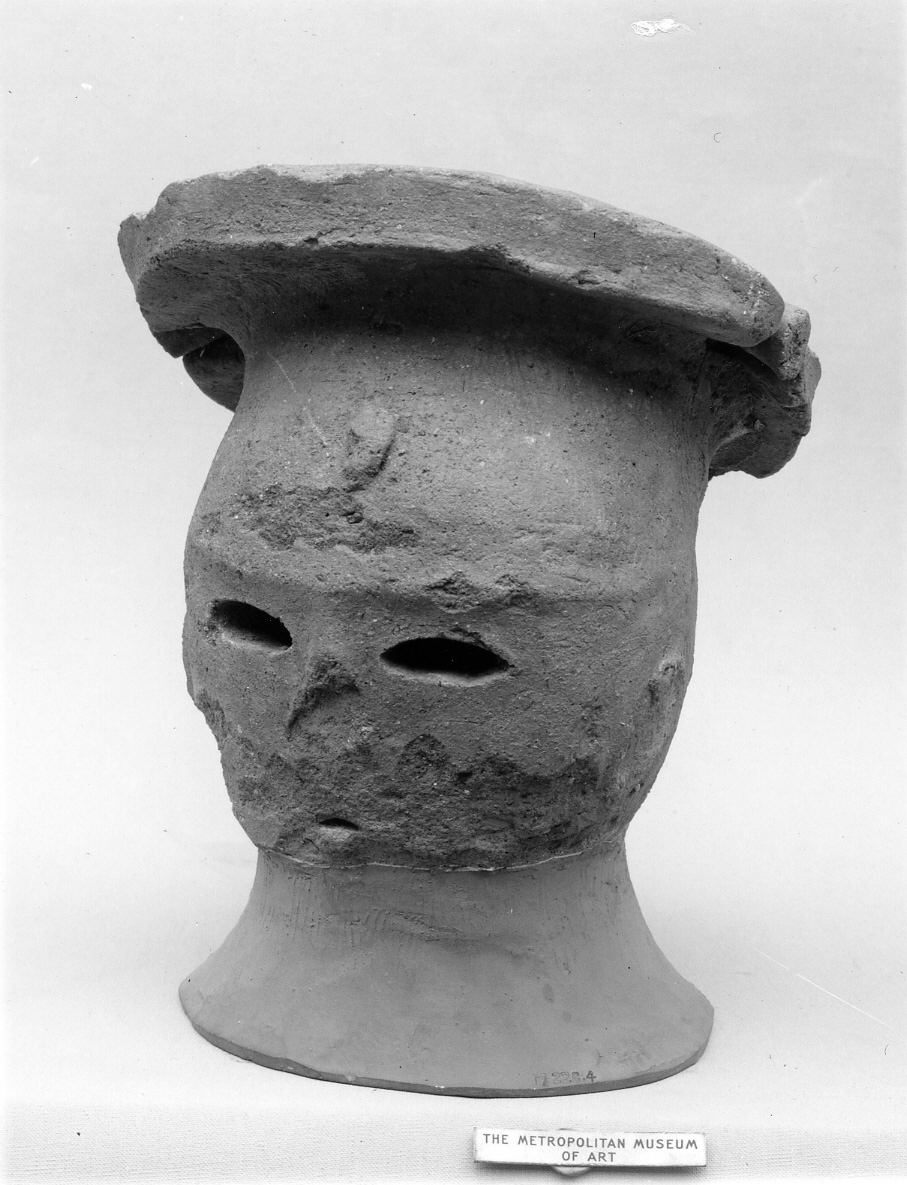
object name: haniwa head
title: Head of a Female Haniwa Figure with Headdress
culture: japanese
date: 401-700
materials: earthenware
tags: heads